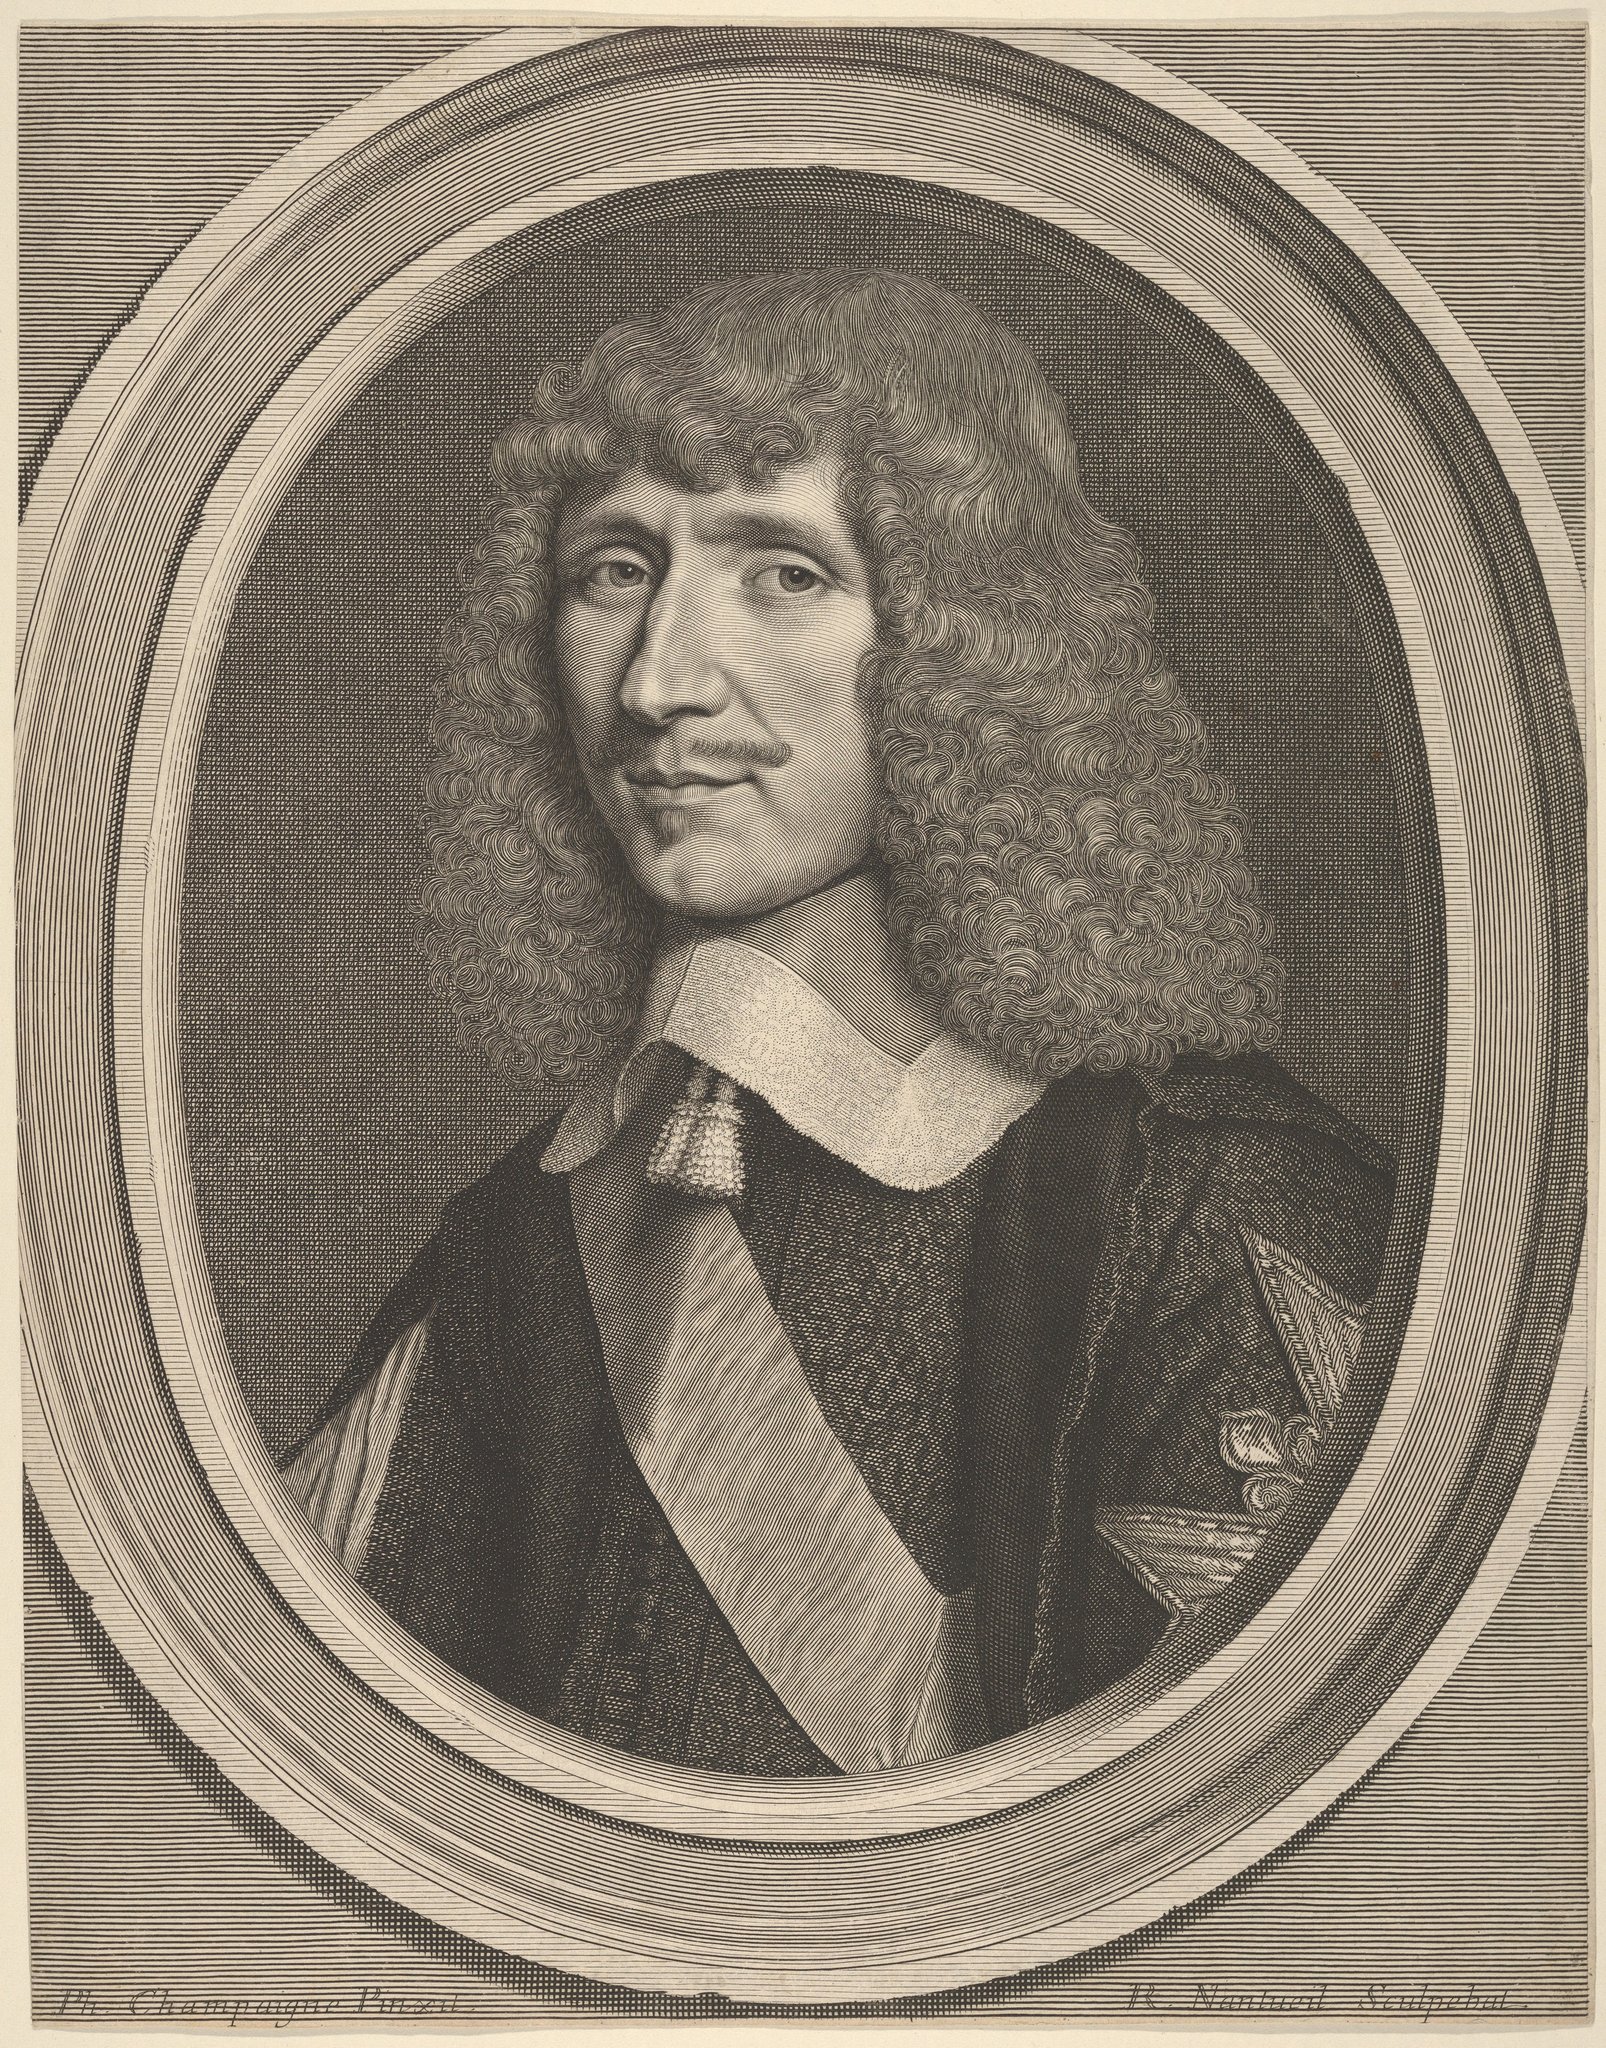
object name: print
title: Léon-Bouthillier, Comte de Chavigny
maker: robert nanteuil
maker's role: artist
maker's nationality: french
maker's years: 1623-1678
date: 1651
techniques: engraving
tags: men,portraits